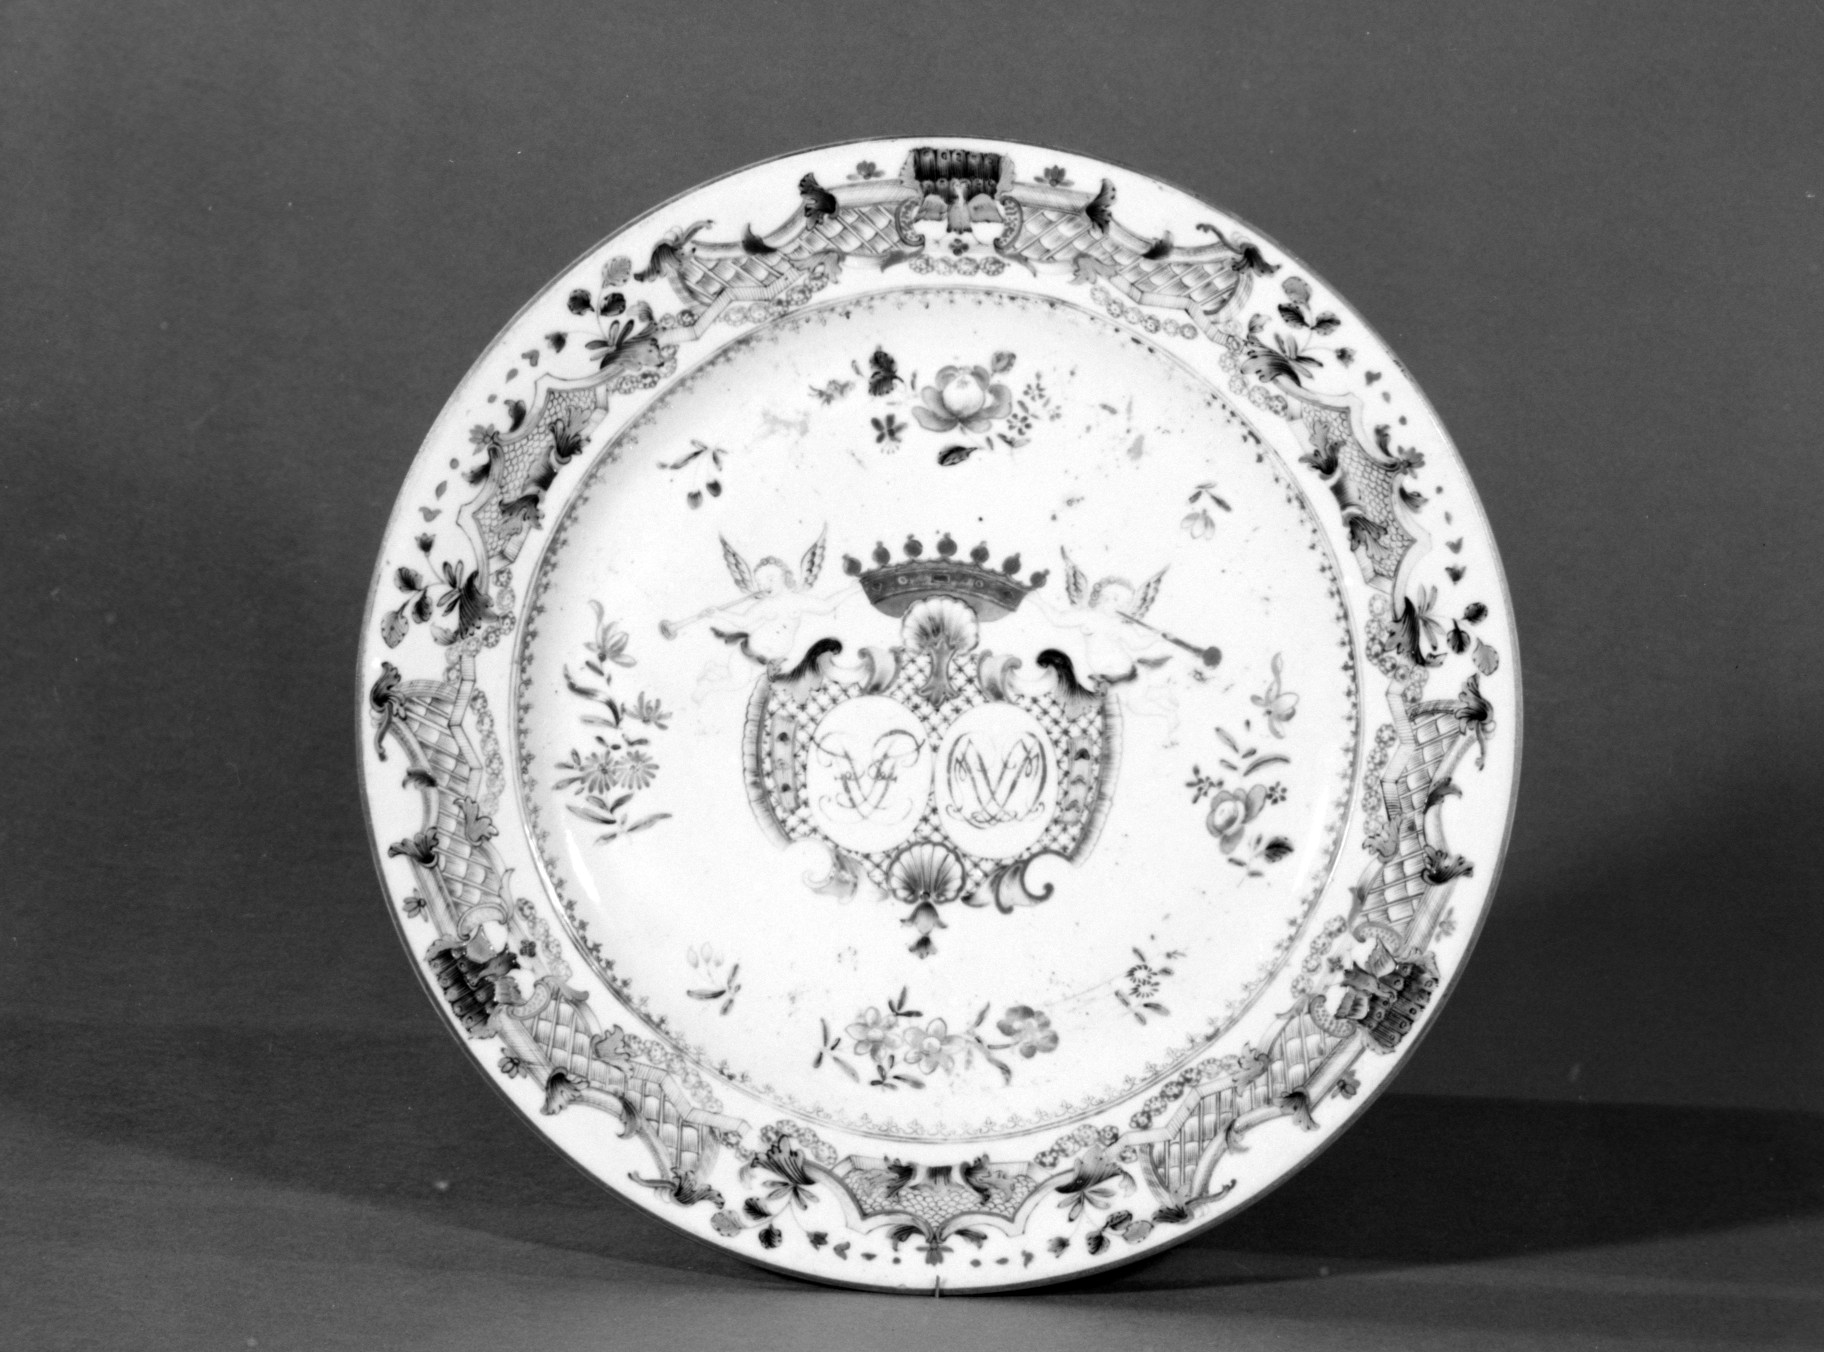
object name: platter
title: Platter (one of a pair)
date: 1760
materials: hard paste porcelain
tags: flowers,coat of arms